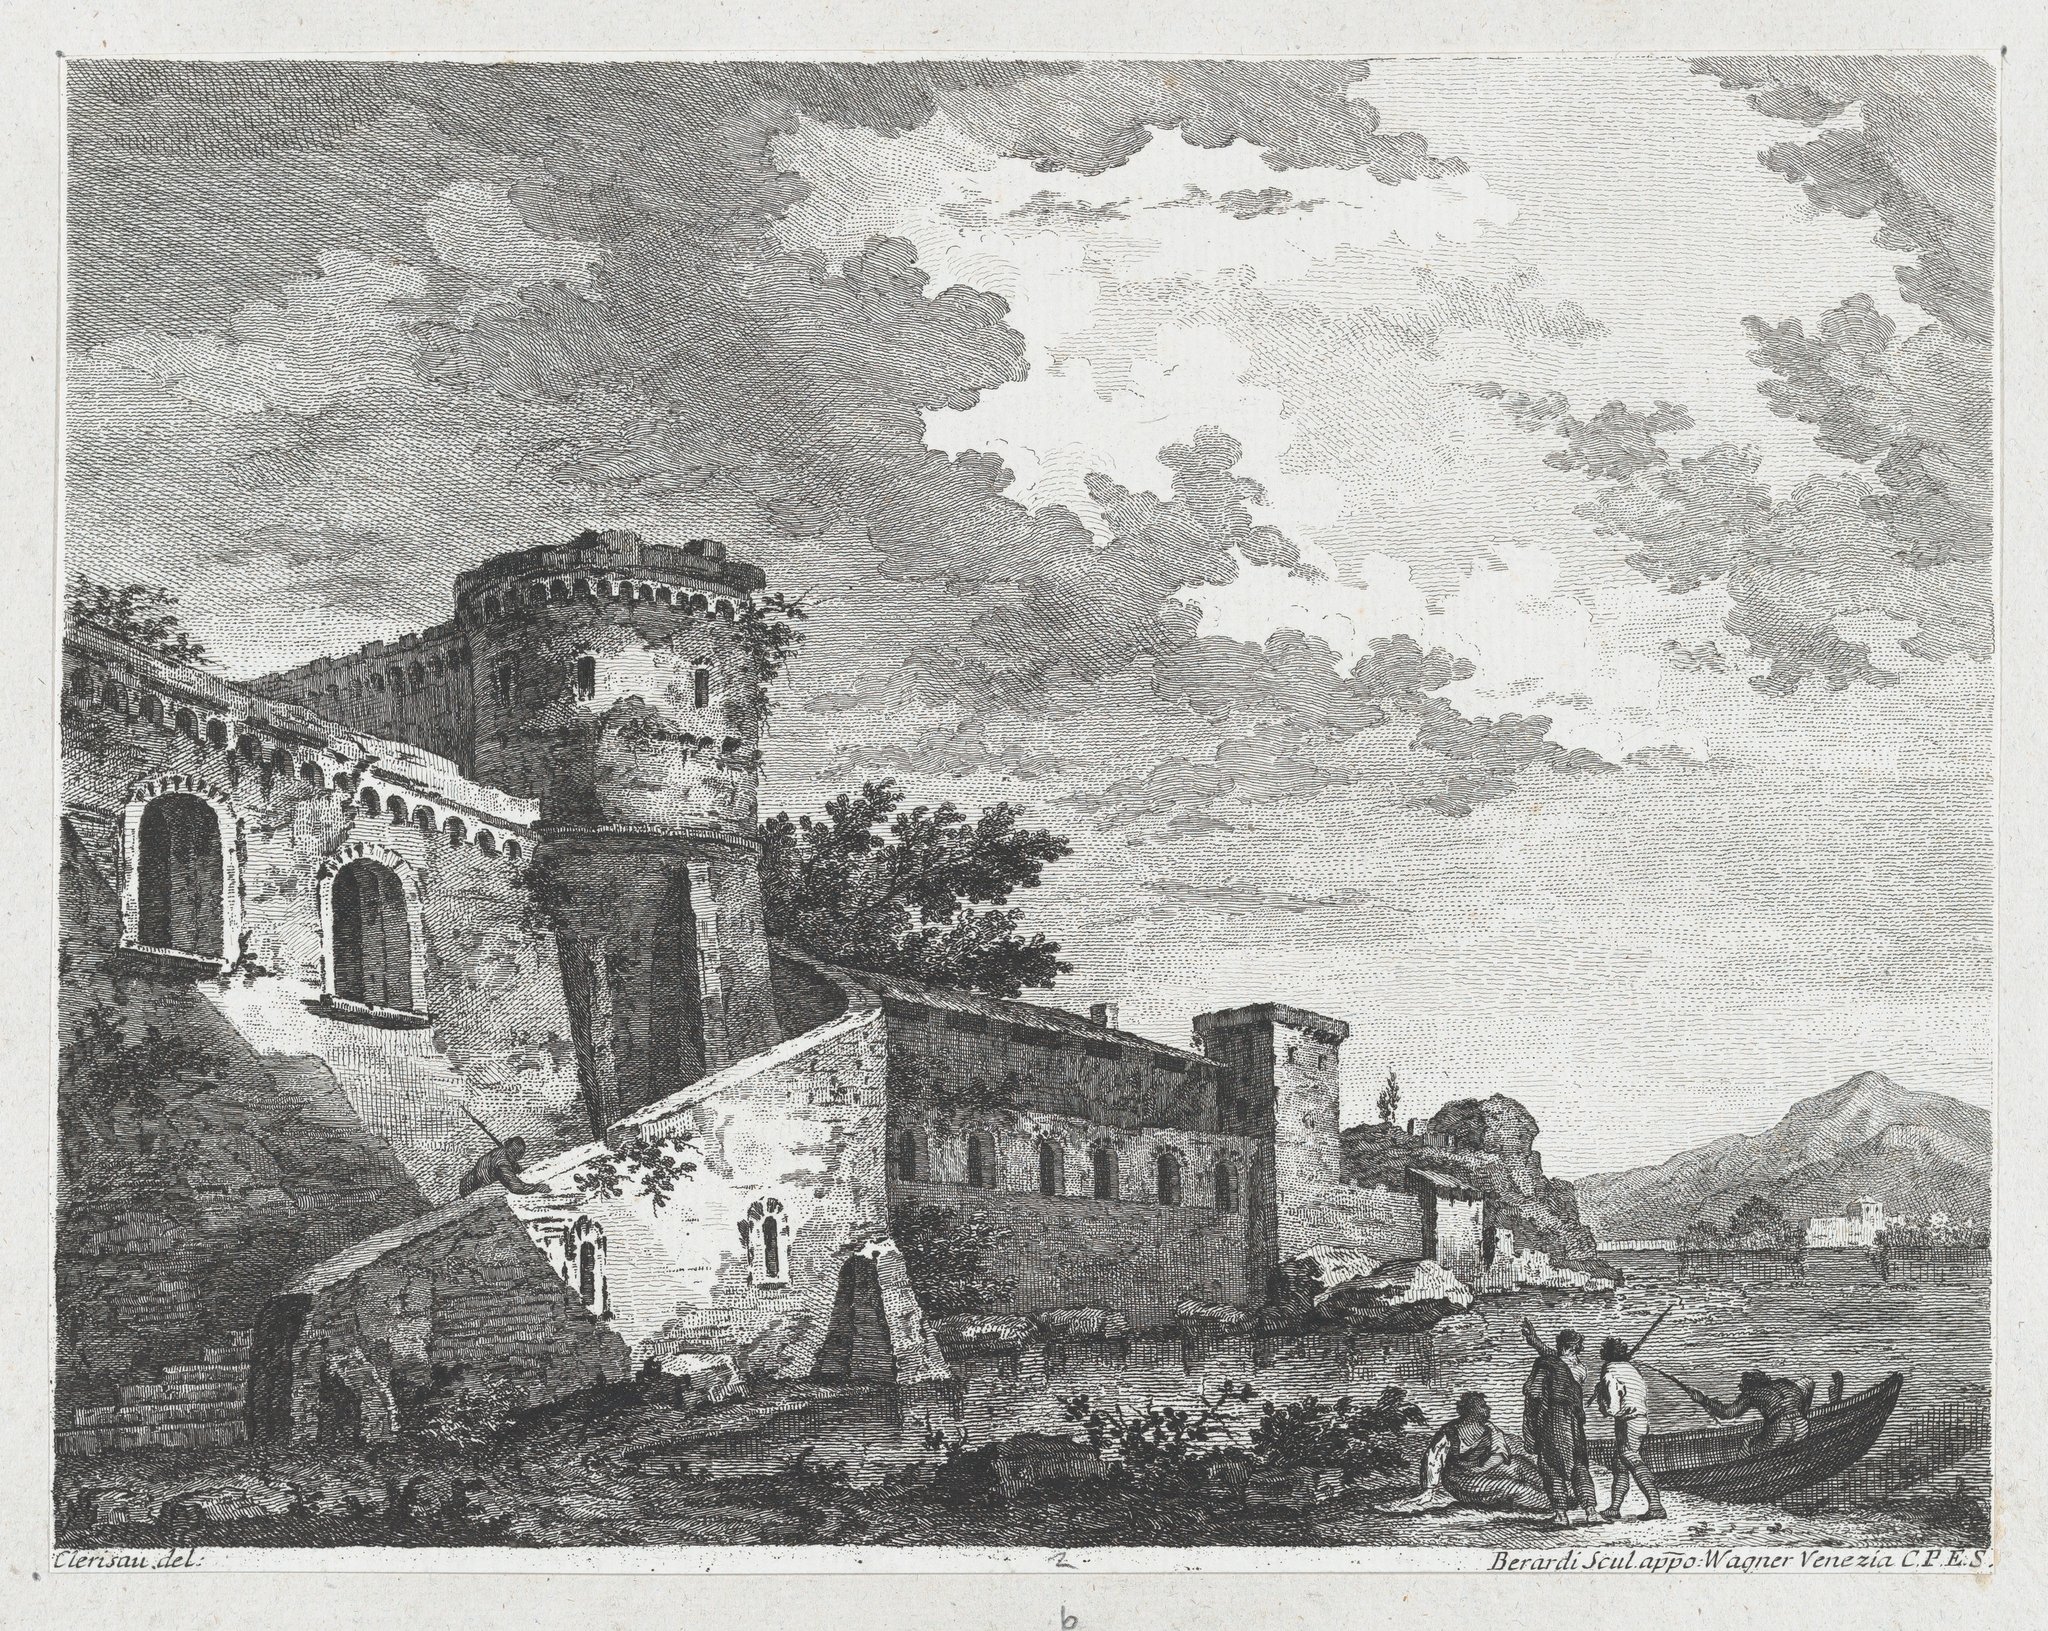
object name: print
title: River Scene with Castle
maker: fabio berardi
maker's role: artist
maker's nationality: italian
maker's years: 1728-1788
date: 1750-1770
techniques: etching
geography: venice